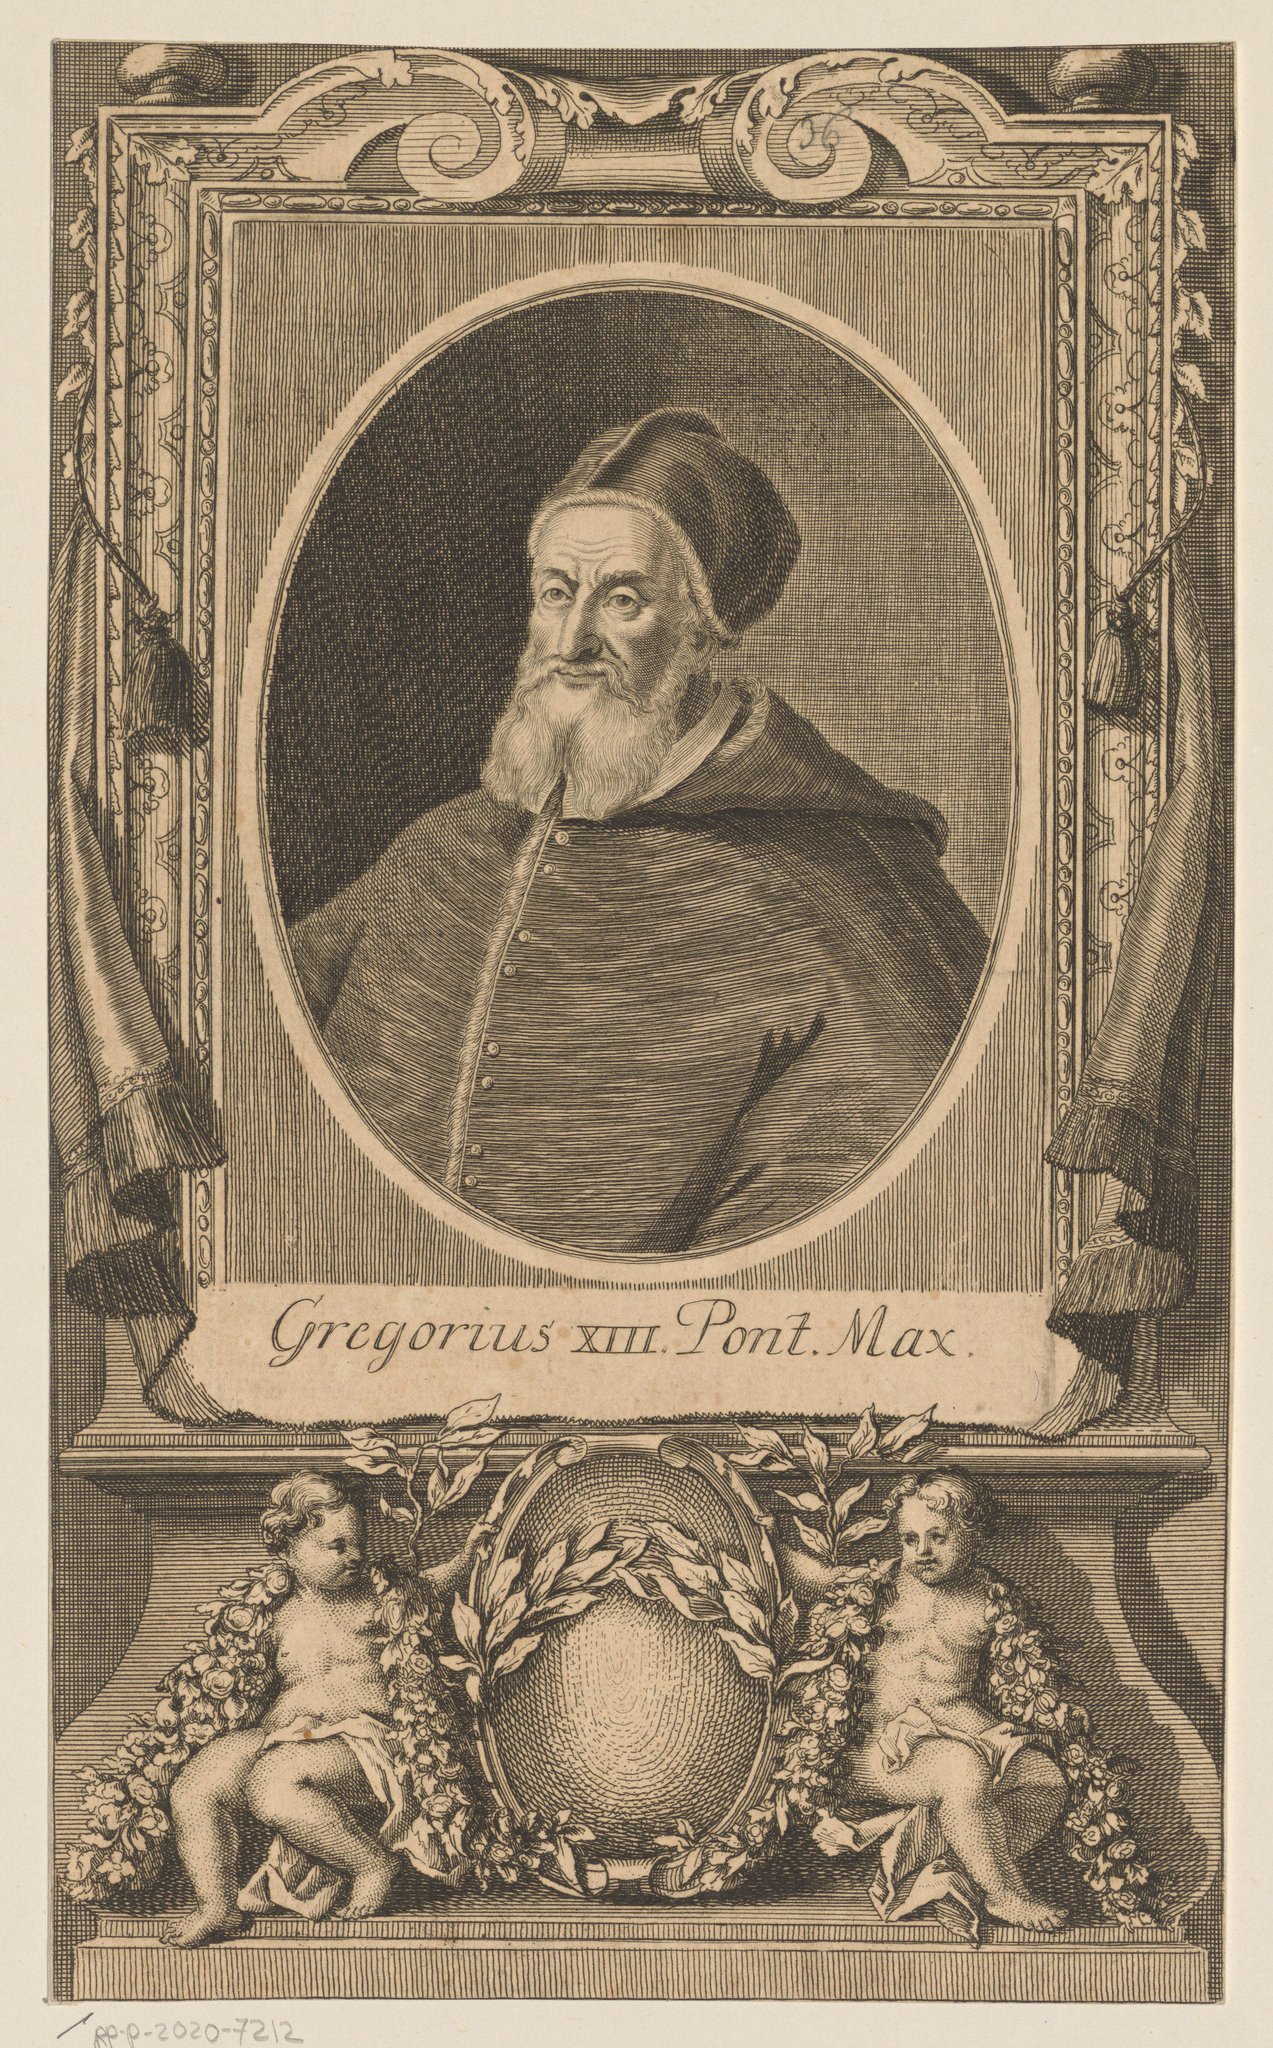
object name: print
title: Portret van paus Gregorius XIII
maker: Anonymous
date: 1650-1750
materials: paper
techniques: engraving, etching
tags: rome, gregorius xiii, historical persons, pope, cupids: 'amores', 'amoretti', 'putti'